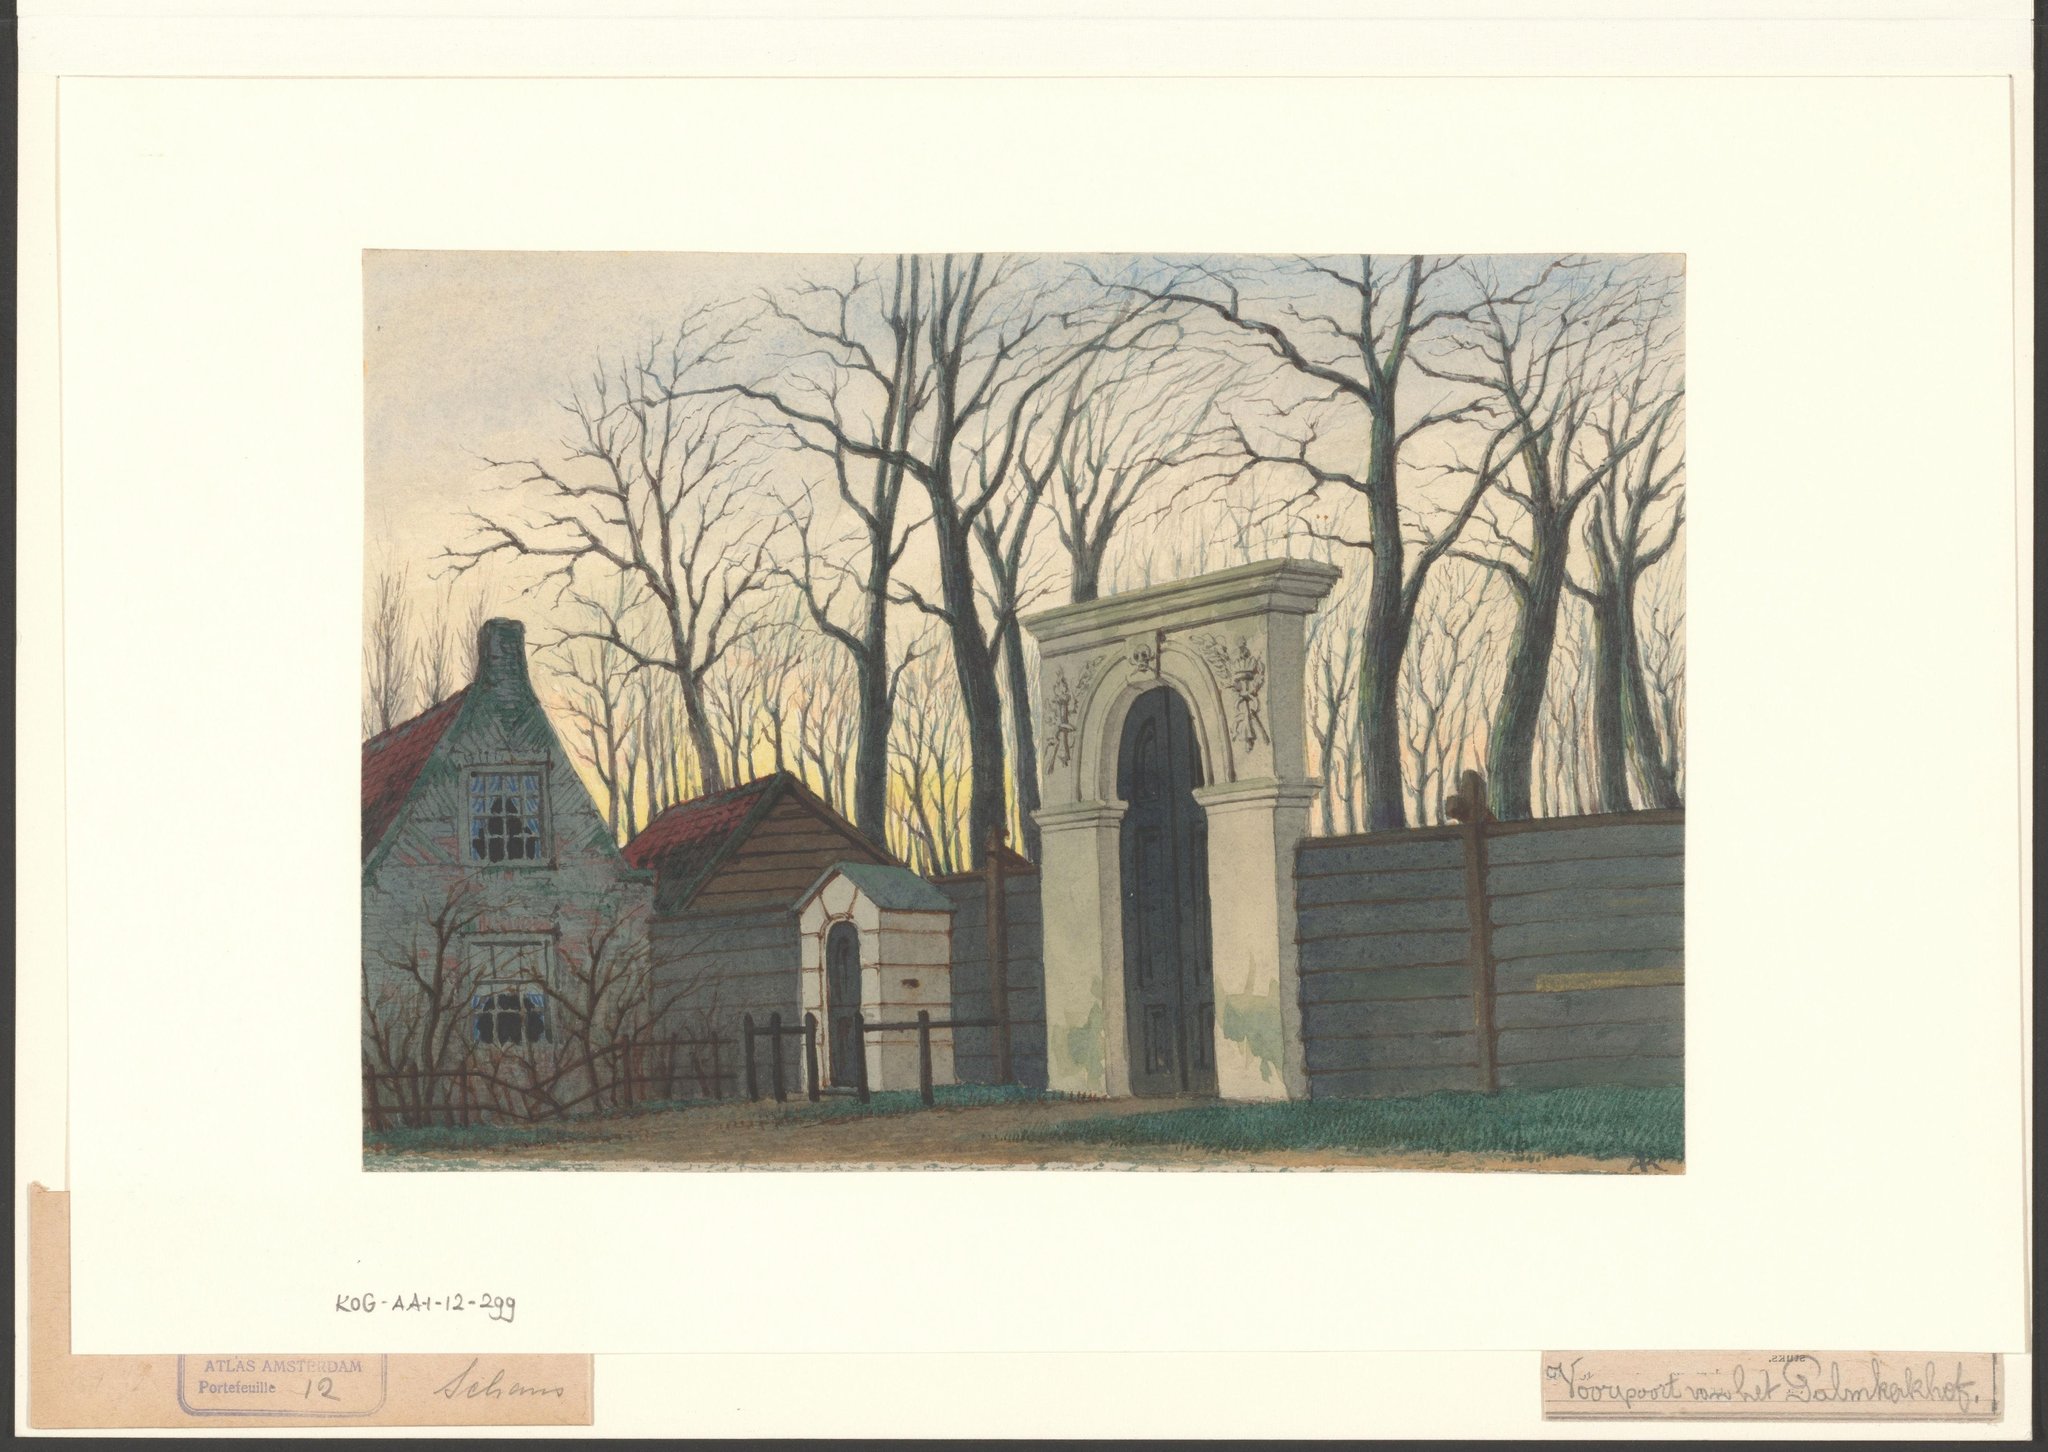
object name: drawing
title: Gezicht op de poort van het Palmkerkhof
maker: johan martinus anthon rieke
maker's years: 1851-1899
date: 1861-1899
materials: gouache, paper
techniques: brush, pen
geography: amsterdam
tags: city-view in general; 'veduta', gate, entrance, cemetery, park-like burying ground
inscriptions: collector's mark: Lugt 2138d, signature: ‘Palmkerkhof / JMA Rieke’, collector's mark: ‘12’ Lugt 1641b, inscription: ‘Voorpoort van het Palmkerkhof’, stamp: ‘Van het Koninklijk / Oudheidkundig Genootschap / te Amsterdam’, inscription: ‘Port. 12-299’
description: Onderwerpsrubriek binnen de Atlas Amsterdam: Sarphatistraat, Schans.